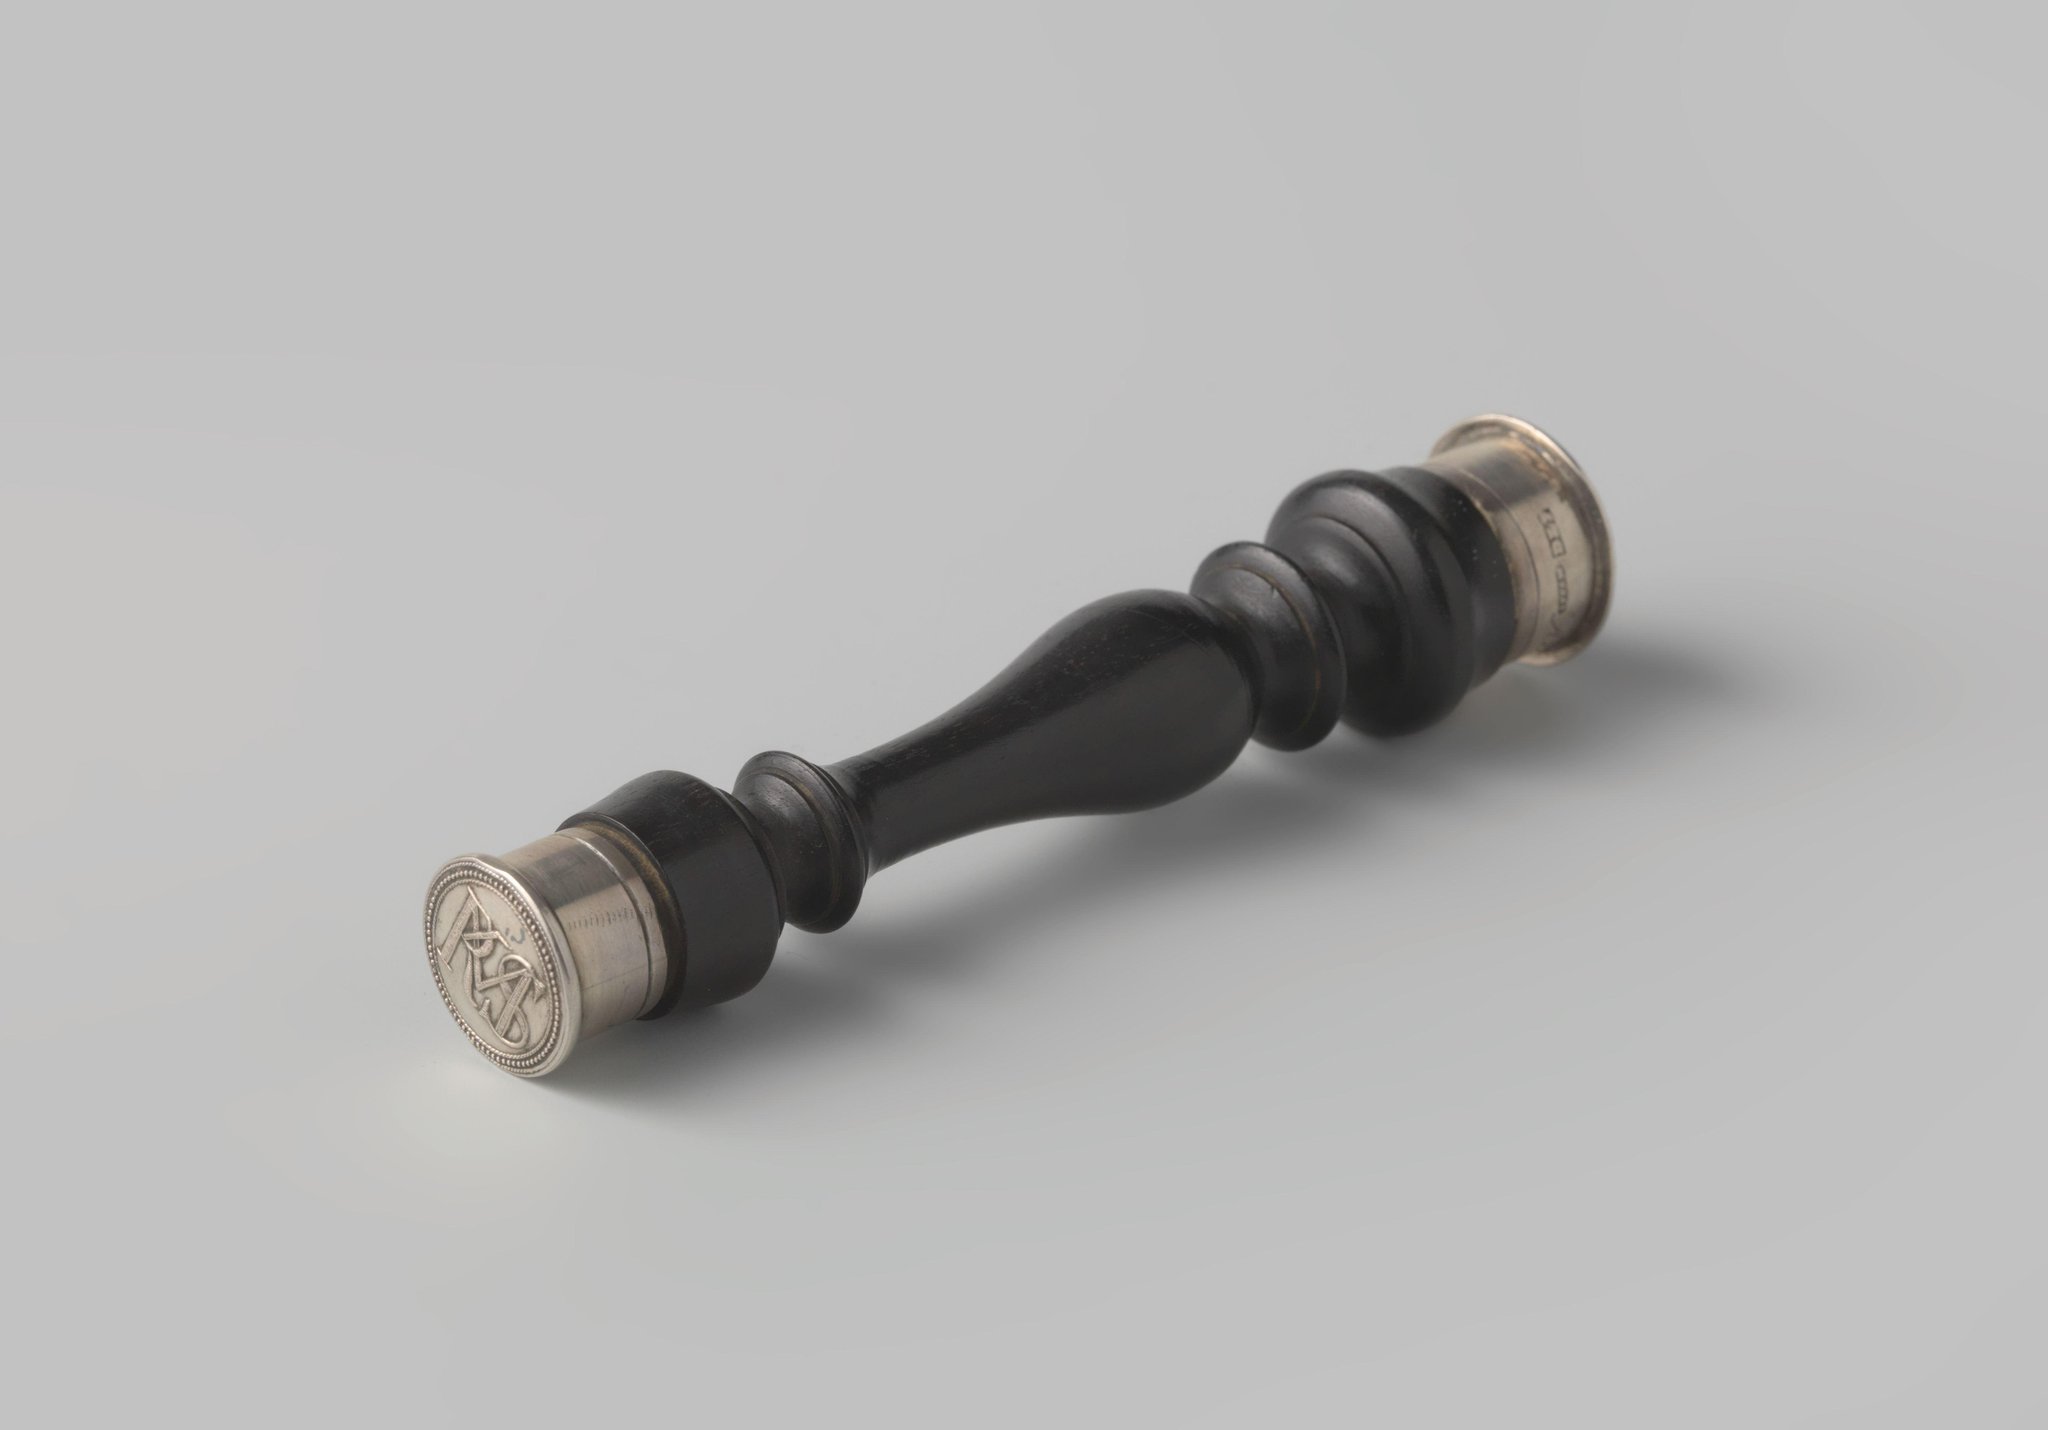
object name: staff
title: Deurwaardersstaf van ebbenhout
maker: heer van loenen en meinerswijk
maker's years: -1614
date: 1757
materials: wood, silver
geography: amsterdam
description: Ebbenhouten staf met aan de ene zijde een cachet met monogram 'RMS' in parelrand. Aan de andere kant het wapen van Amsterdam in zilver in relief.